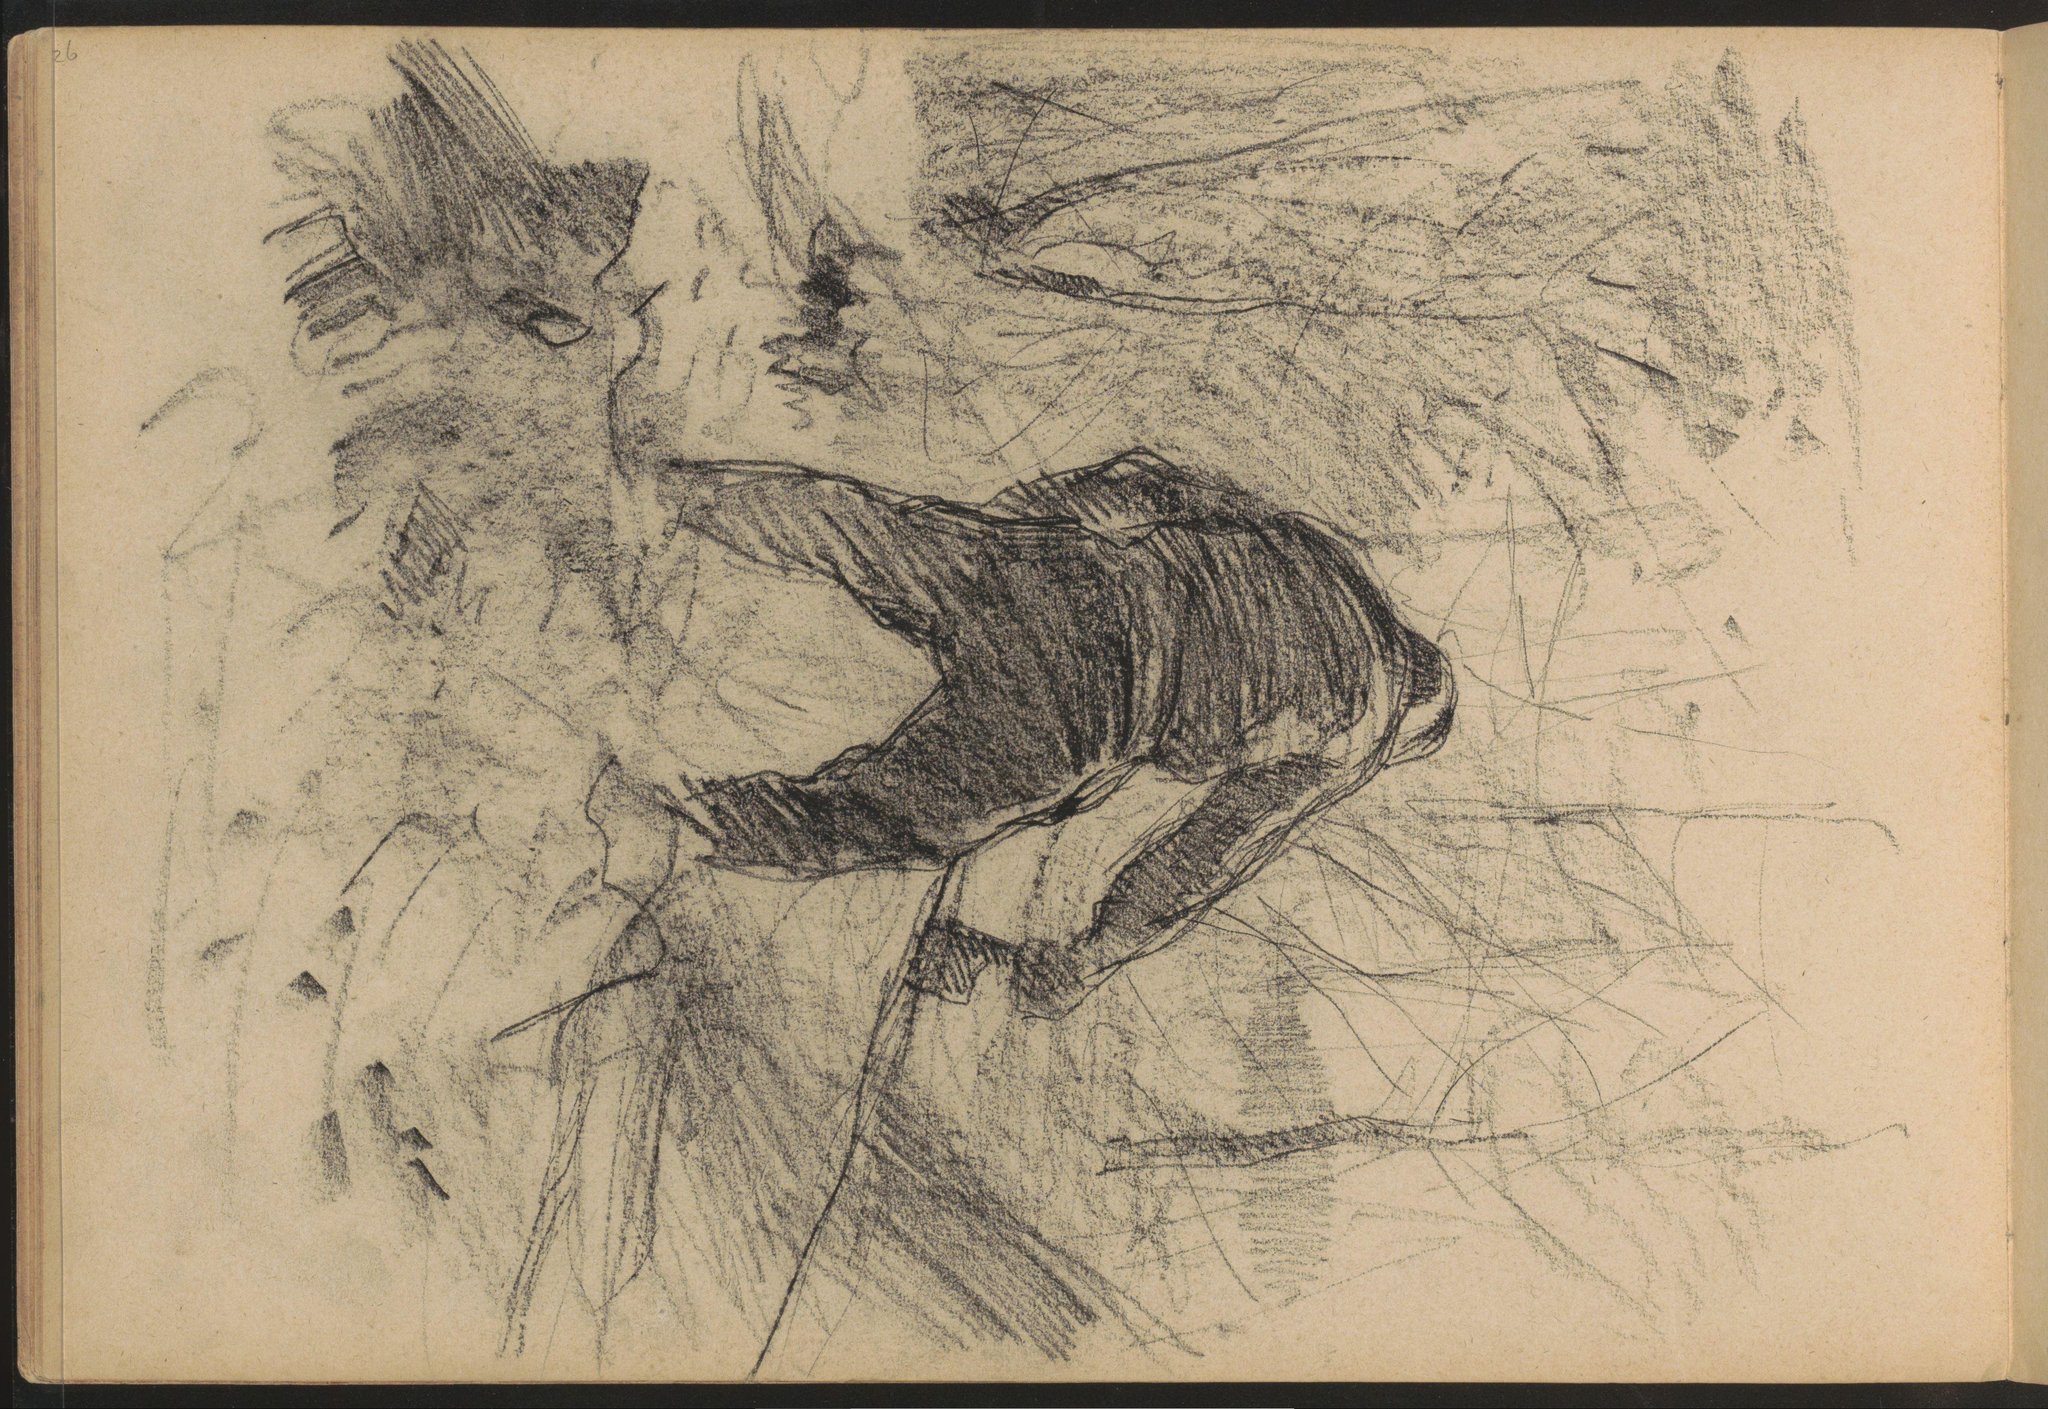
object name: sketchbook leaf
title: Boer aan het werk, op de rug gezien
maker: willem witsen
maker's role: draughtsman, painter, print maker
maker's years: 1860-1923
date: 1884-1887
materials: chalk, paper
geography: ewijkshoeve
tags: cultivation ~ agriculture (+ men (labourers)), landscapes in the temperate zone, farmers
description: Op de achtergrond bomen. Pagina 26 uit een schetsboek met 29 bladen.